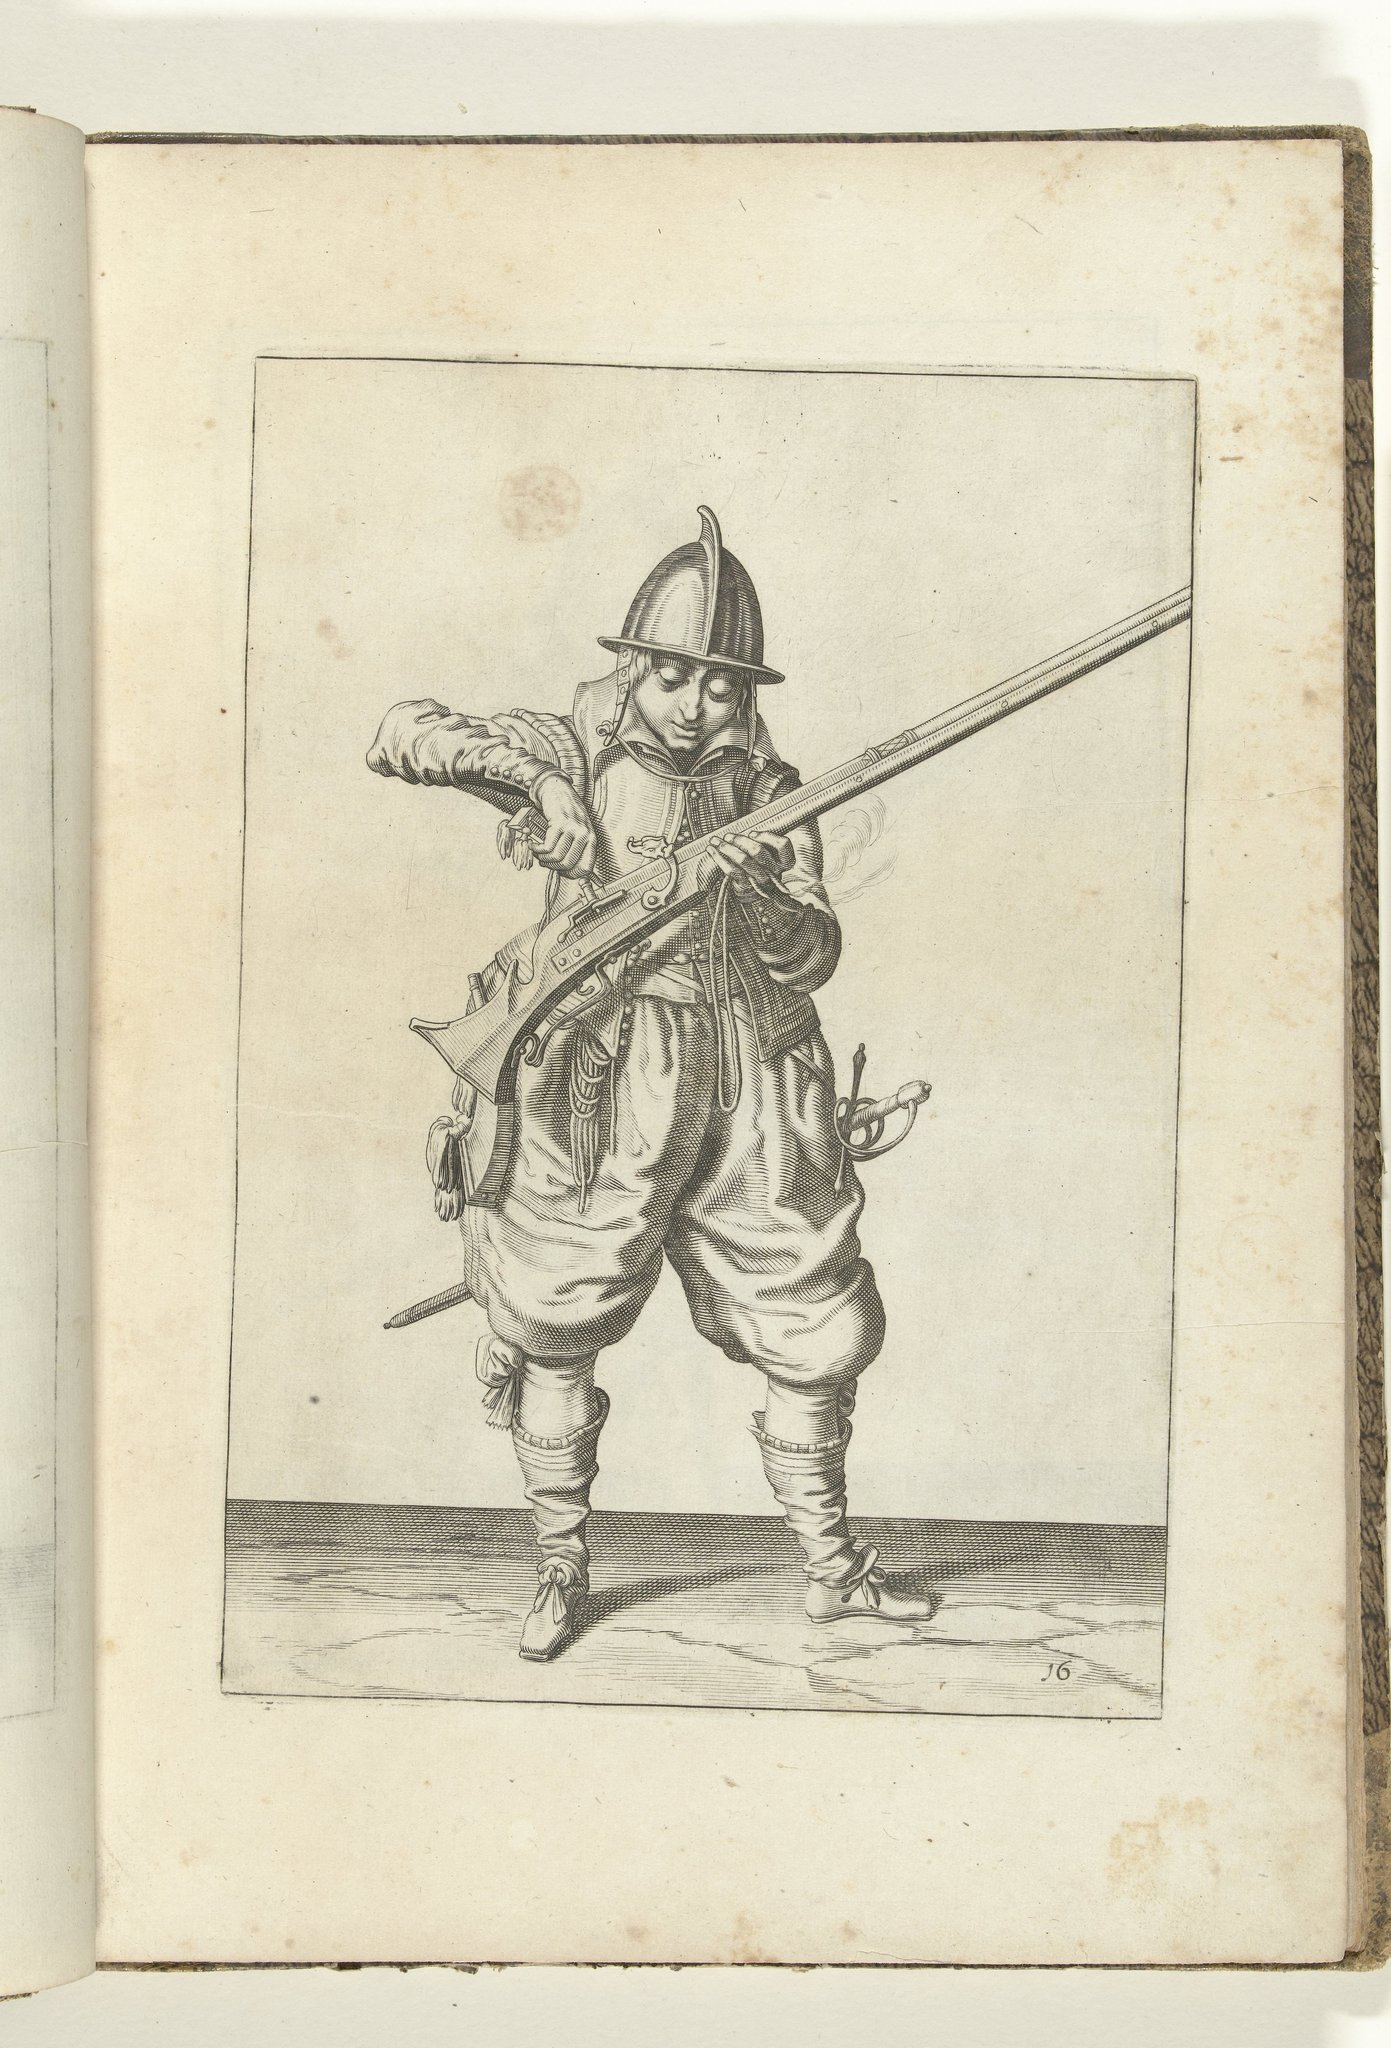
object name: print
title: Soldaat die kruit in de pan van zijn roer giet (nr. 16), ca. 1600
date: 1597-1608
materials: paper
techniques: engraving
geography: amsterdam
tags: maurice (prince of orange), handling of weapons ~ military training, weapons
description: Een soldaat, ten voeten uit, die kruit uit een kruitfles in de pan (het kruitreservoir) van een roer (een bepaald type vuurwapen) giet (nr. 16), ca. 1600. In zijn linkerhand behalve het roer ook een brandende lont. Plaat 16 in de instructies voor het hanteren van de roer: Corte onderwysinghe op de figuerliicke afbeeldinghe, belanghende t'rechte ghebruyck des Roers. Onderdeel van de illustraties in: J. de Gheyn, Wapenhandelinghe van Roers Musquetten ende spiessen, 's-Gravenhage, 1607. Krijgswezen rond 1600.